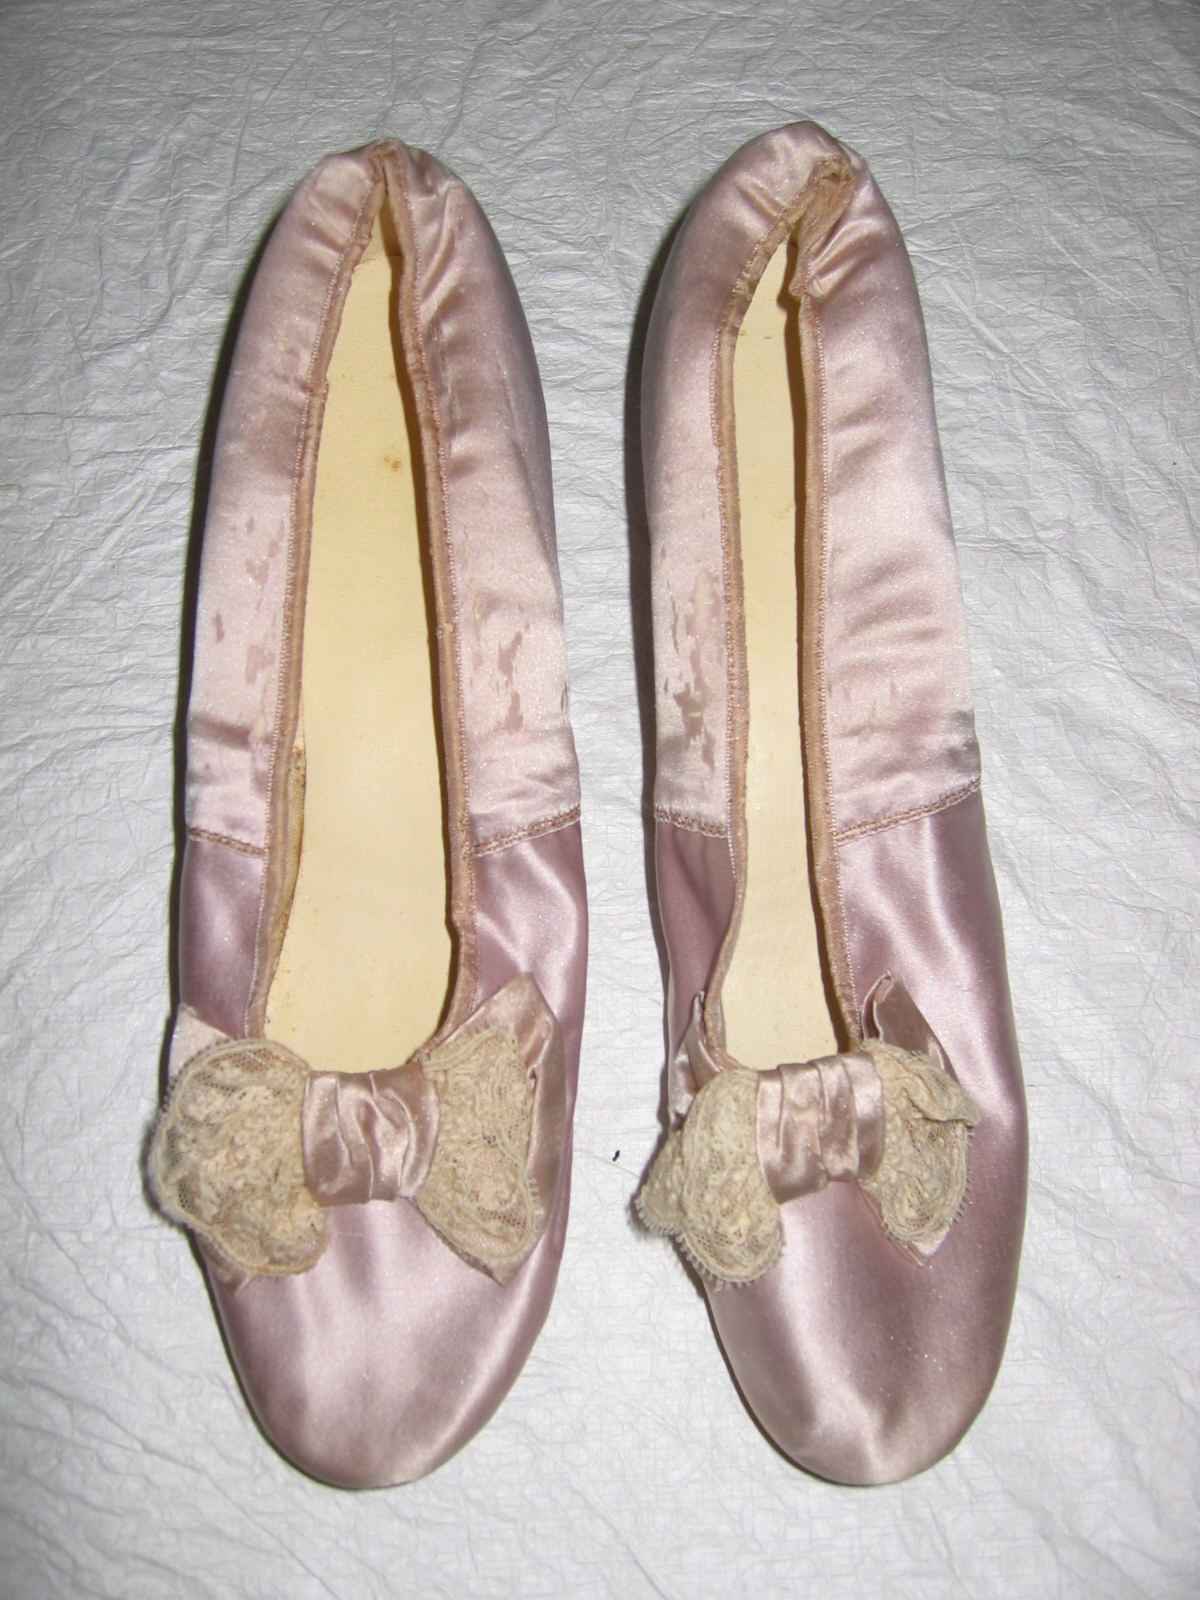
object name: shoe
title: Shoes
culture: french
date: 1888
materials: silk